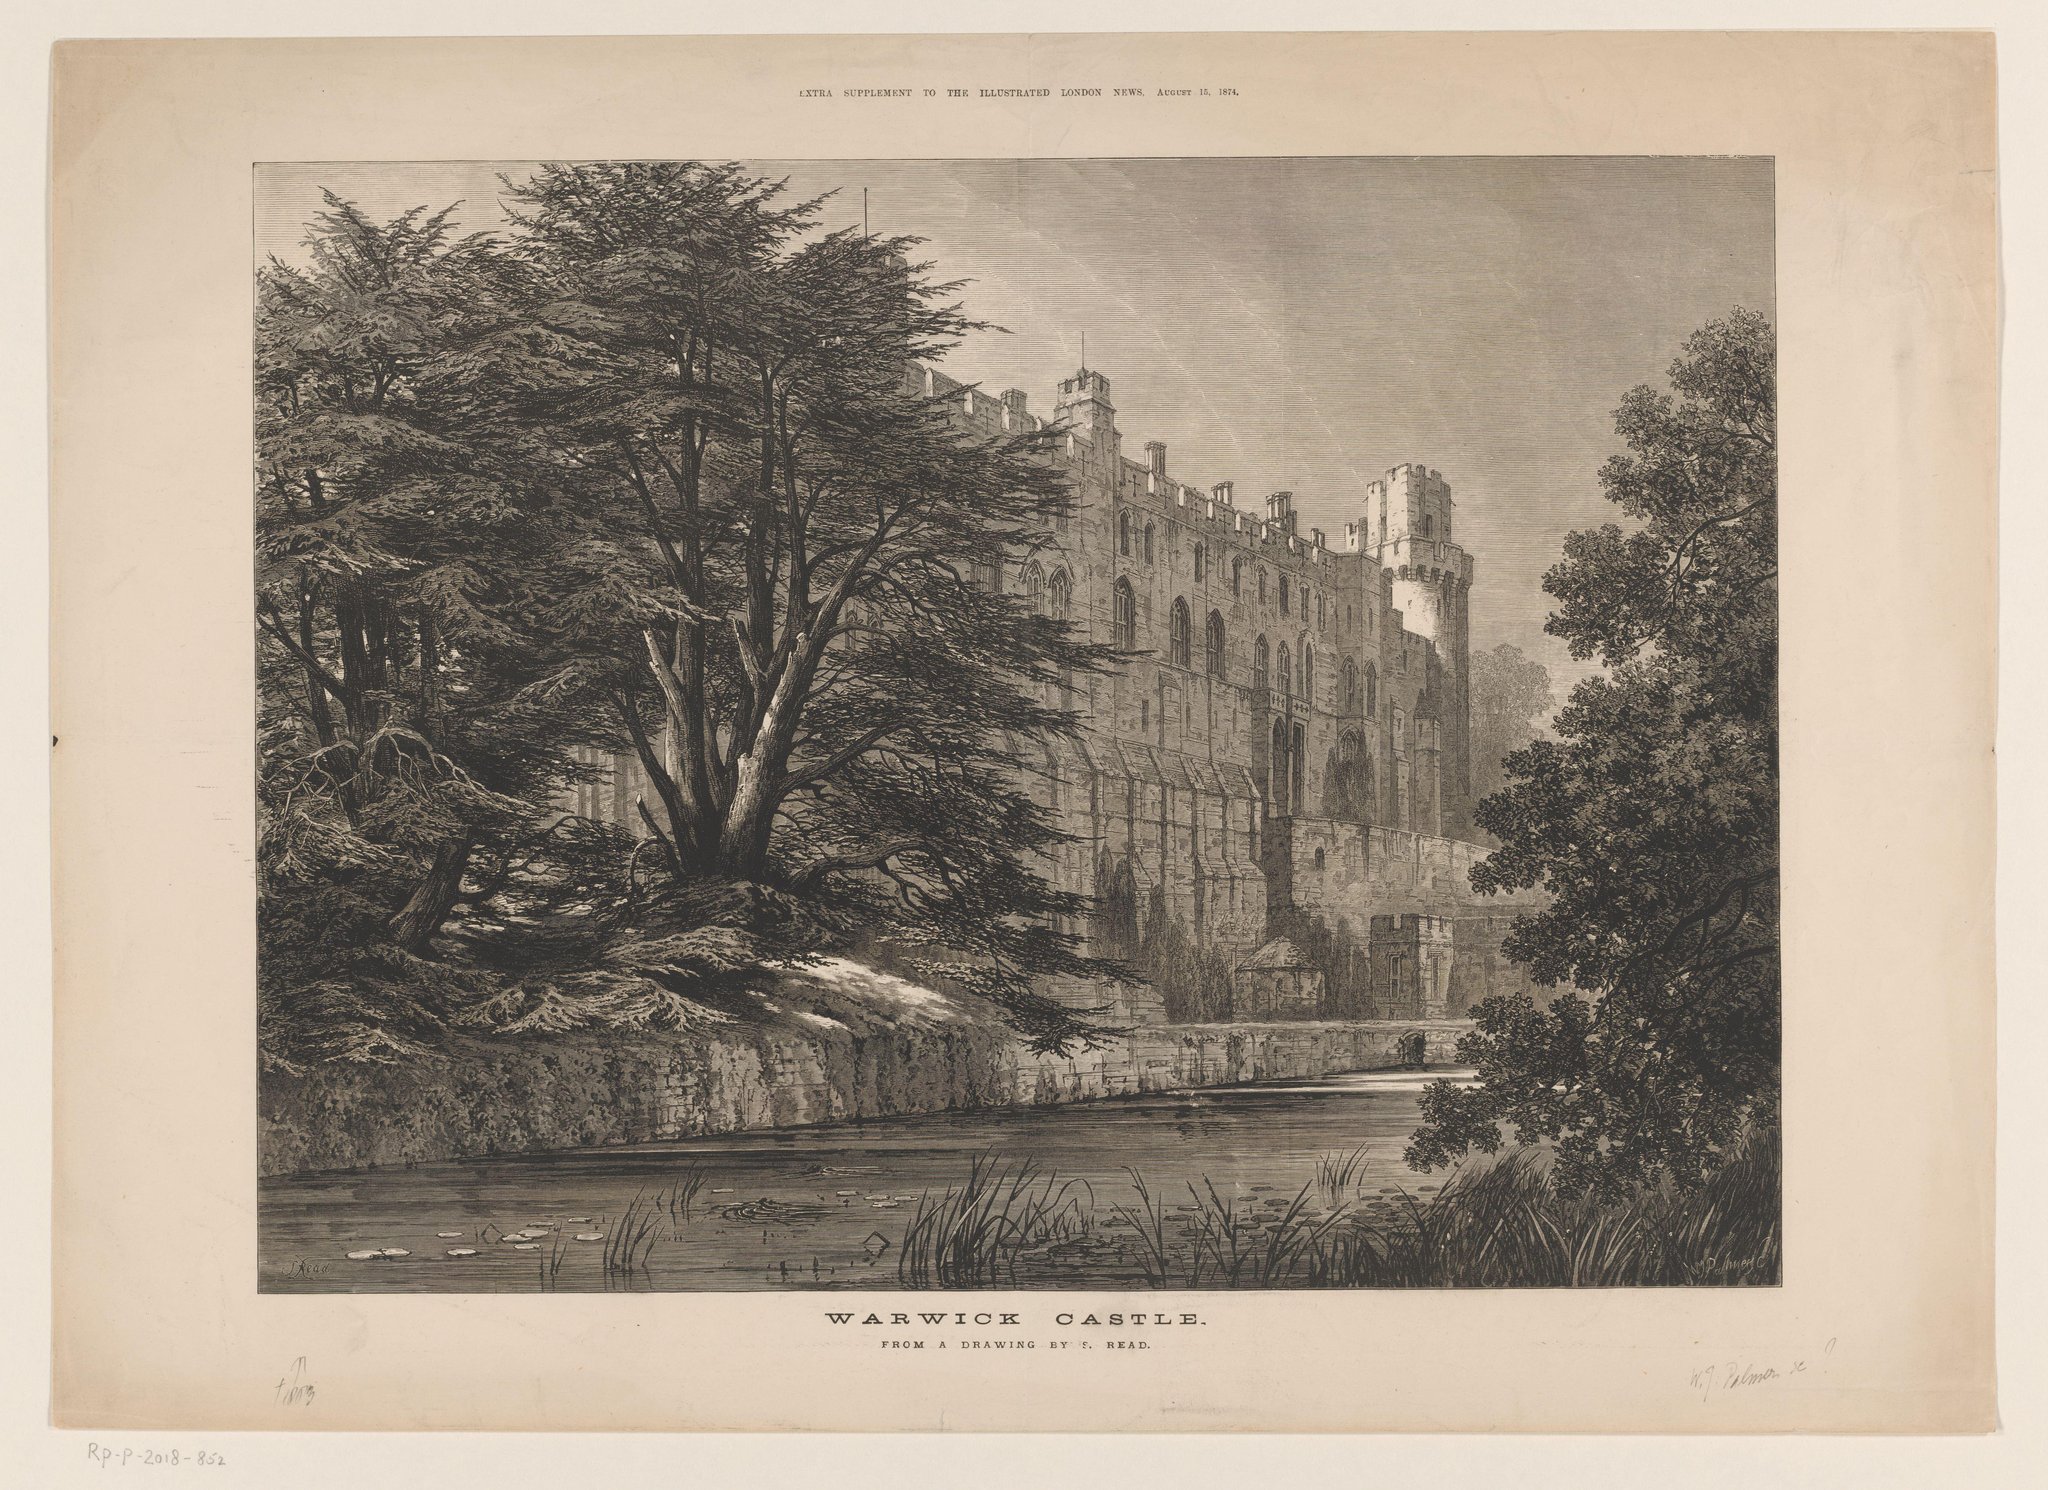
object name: print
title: Gezicht op Warwick Castle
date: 1874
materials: paper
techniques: engraving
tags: castle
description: Prent gebruikt in: Extra Supplement to The Illustrated London News, 15 augustus 1874.